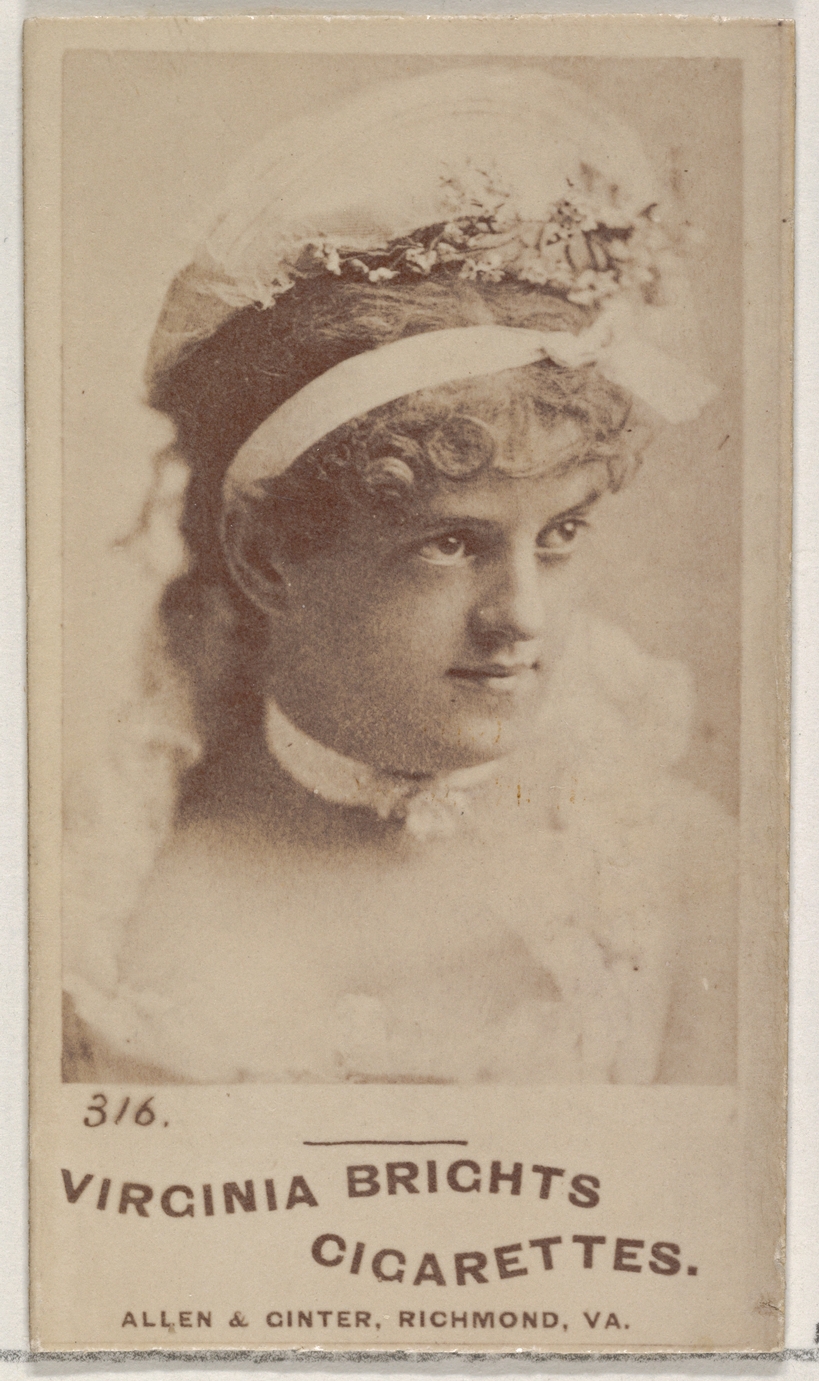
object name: photograph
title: Card 316, from the Actors and Actresses series (N45, Type 5) for Virginia Brights Cigarettes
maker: allen & ginter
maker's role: publisher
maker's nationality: american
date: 1888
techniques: albumen silver print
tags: portraits,women,actresses